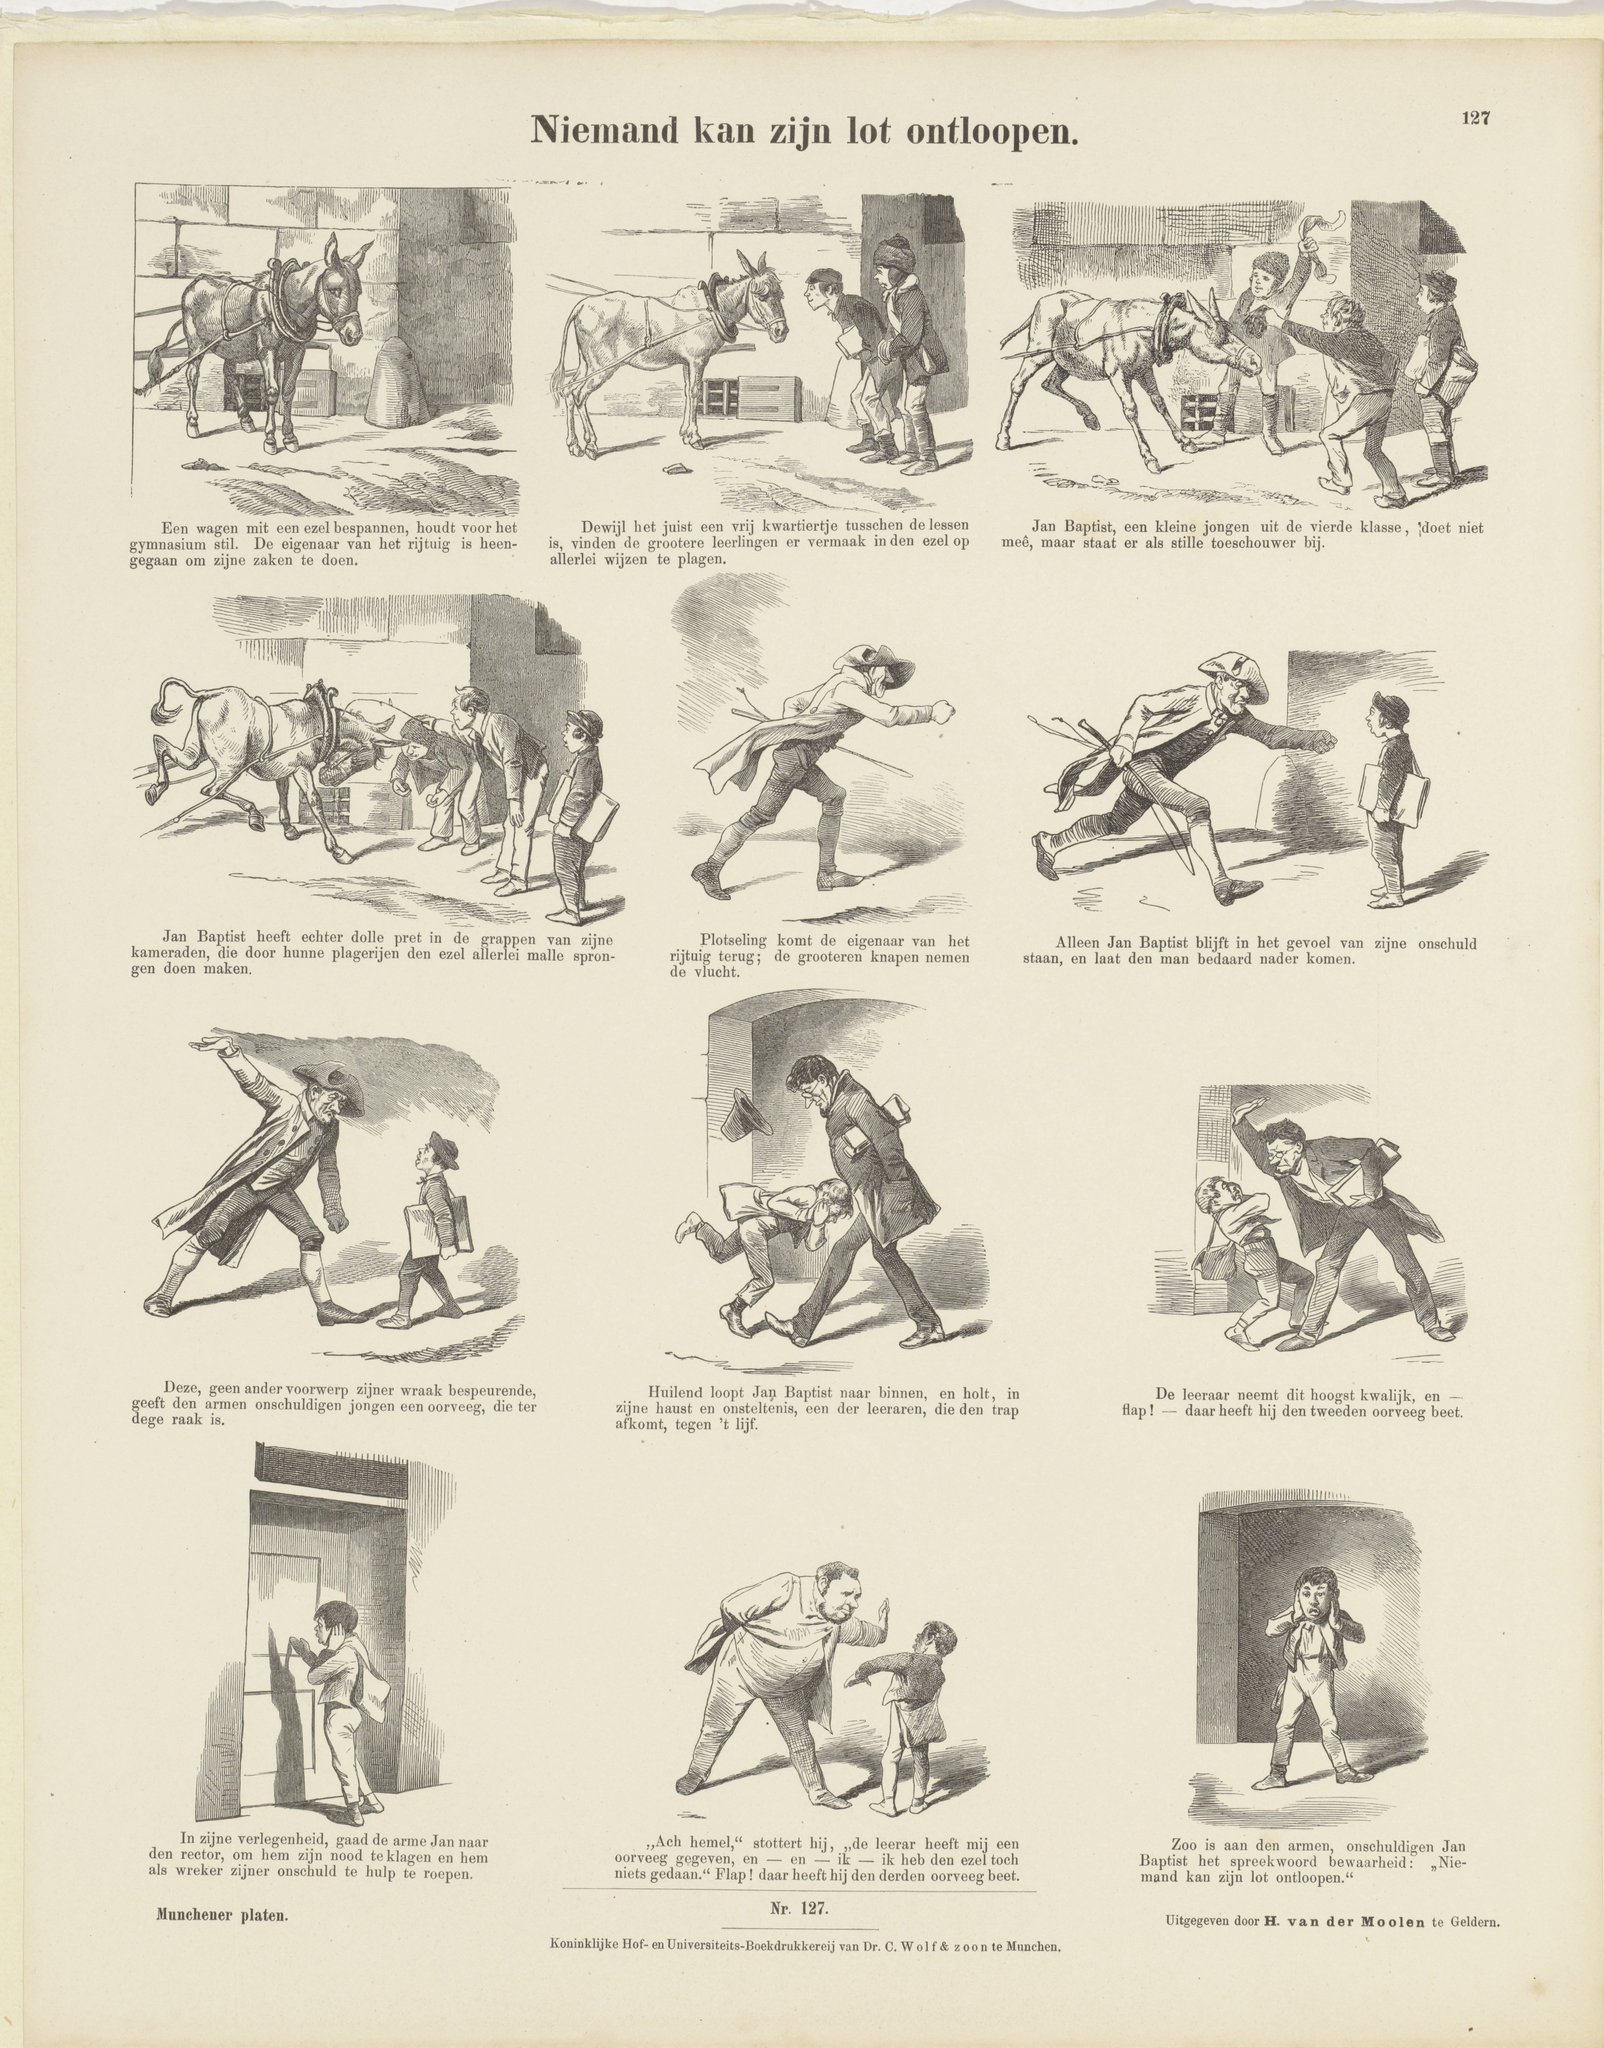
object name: print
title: Munchener platen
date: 1843-1920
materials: paper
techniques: letterpress printing, engraving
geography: geldern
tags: correction of naughty children, child teasing animals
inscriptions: collector's mark: Lugt 2760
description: Blad met 12 voorstellingen over Jan Baptist die onschuldig aan de plagerij van een ezel, daarvoor toch driemaal een oorvijg krijgt. Onder elke afbeelding een onderschrift. Genummerd midden onder: Nro. 127. Genummerd rechtsboven: 127.